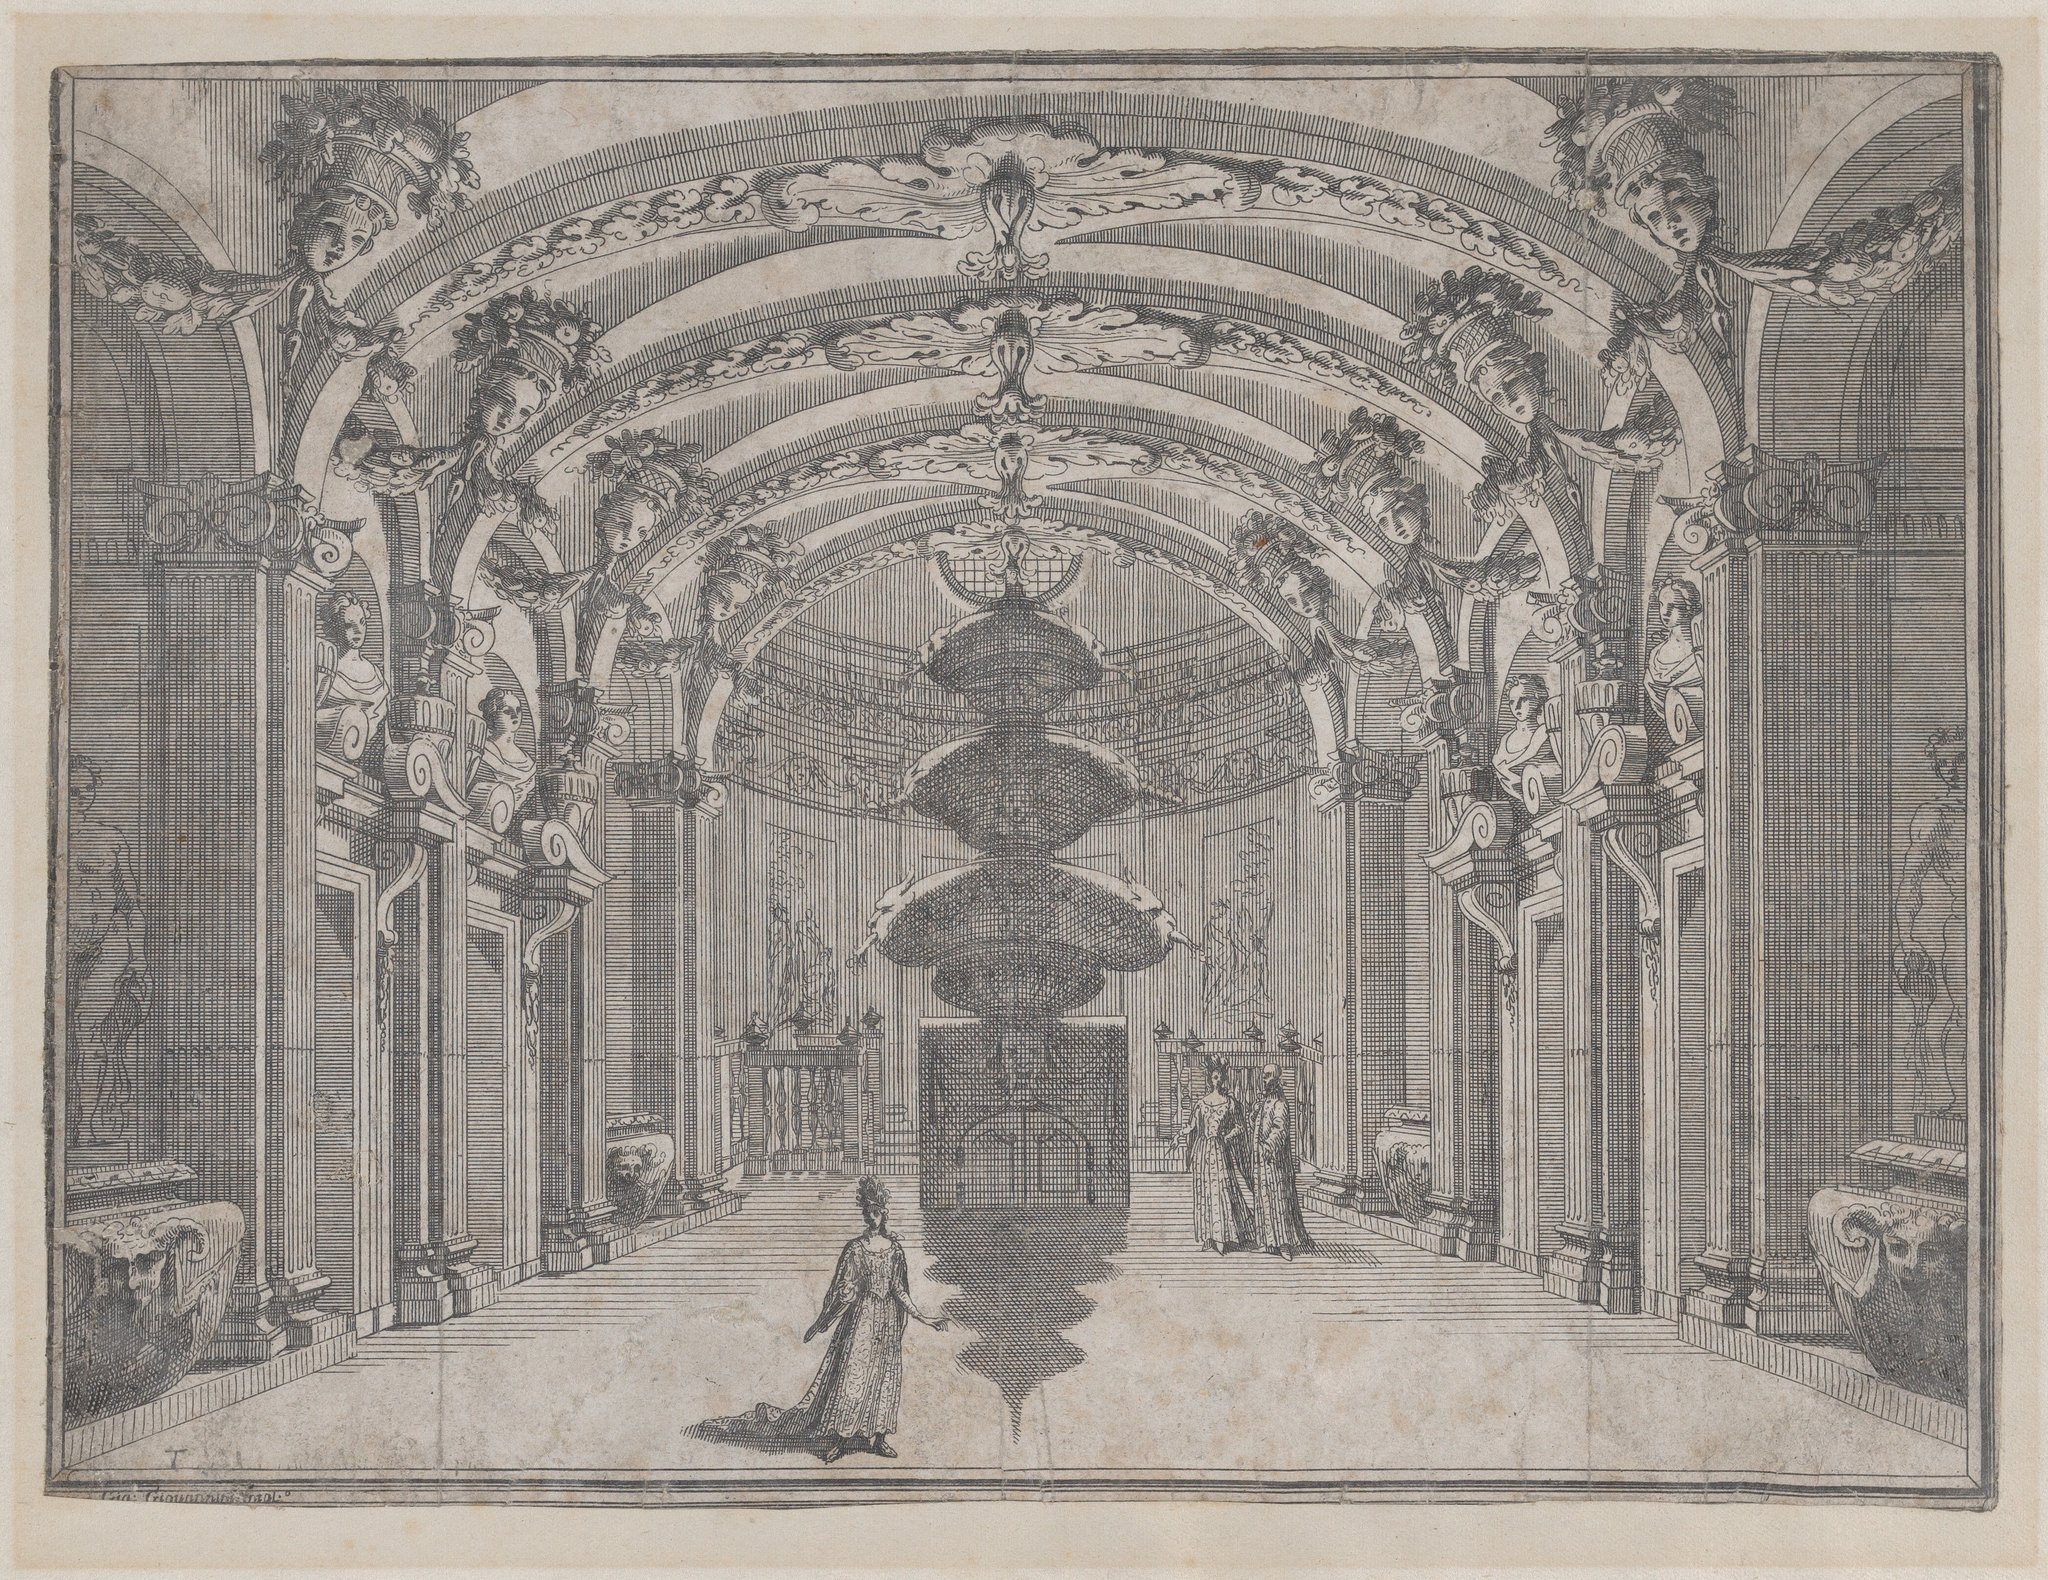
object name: print, fete, ornament architecture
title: Theatrical scene in a great hall with a vaulted ceiling and a central sculpture; two figures converse in the background while a third stands alone in the foreground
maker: giacomo-maria giovannini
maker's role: artist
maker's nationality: italian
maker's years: 1667-1717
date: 1687-1717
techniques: etching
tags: interiors